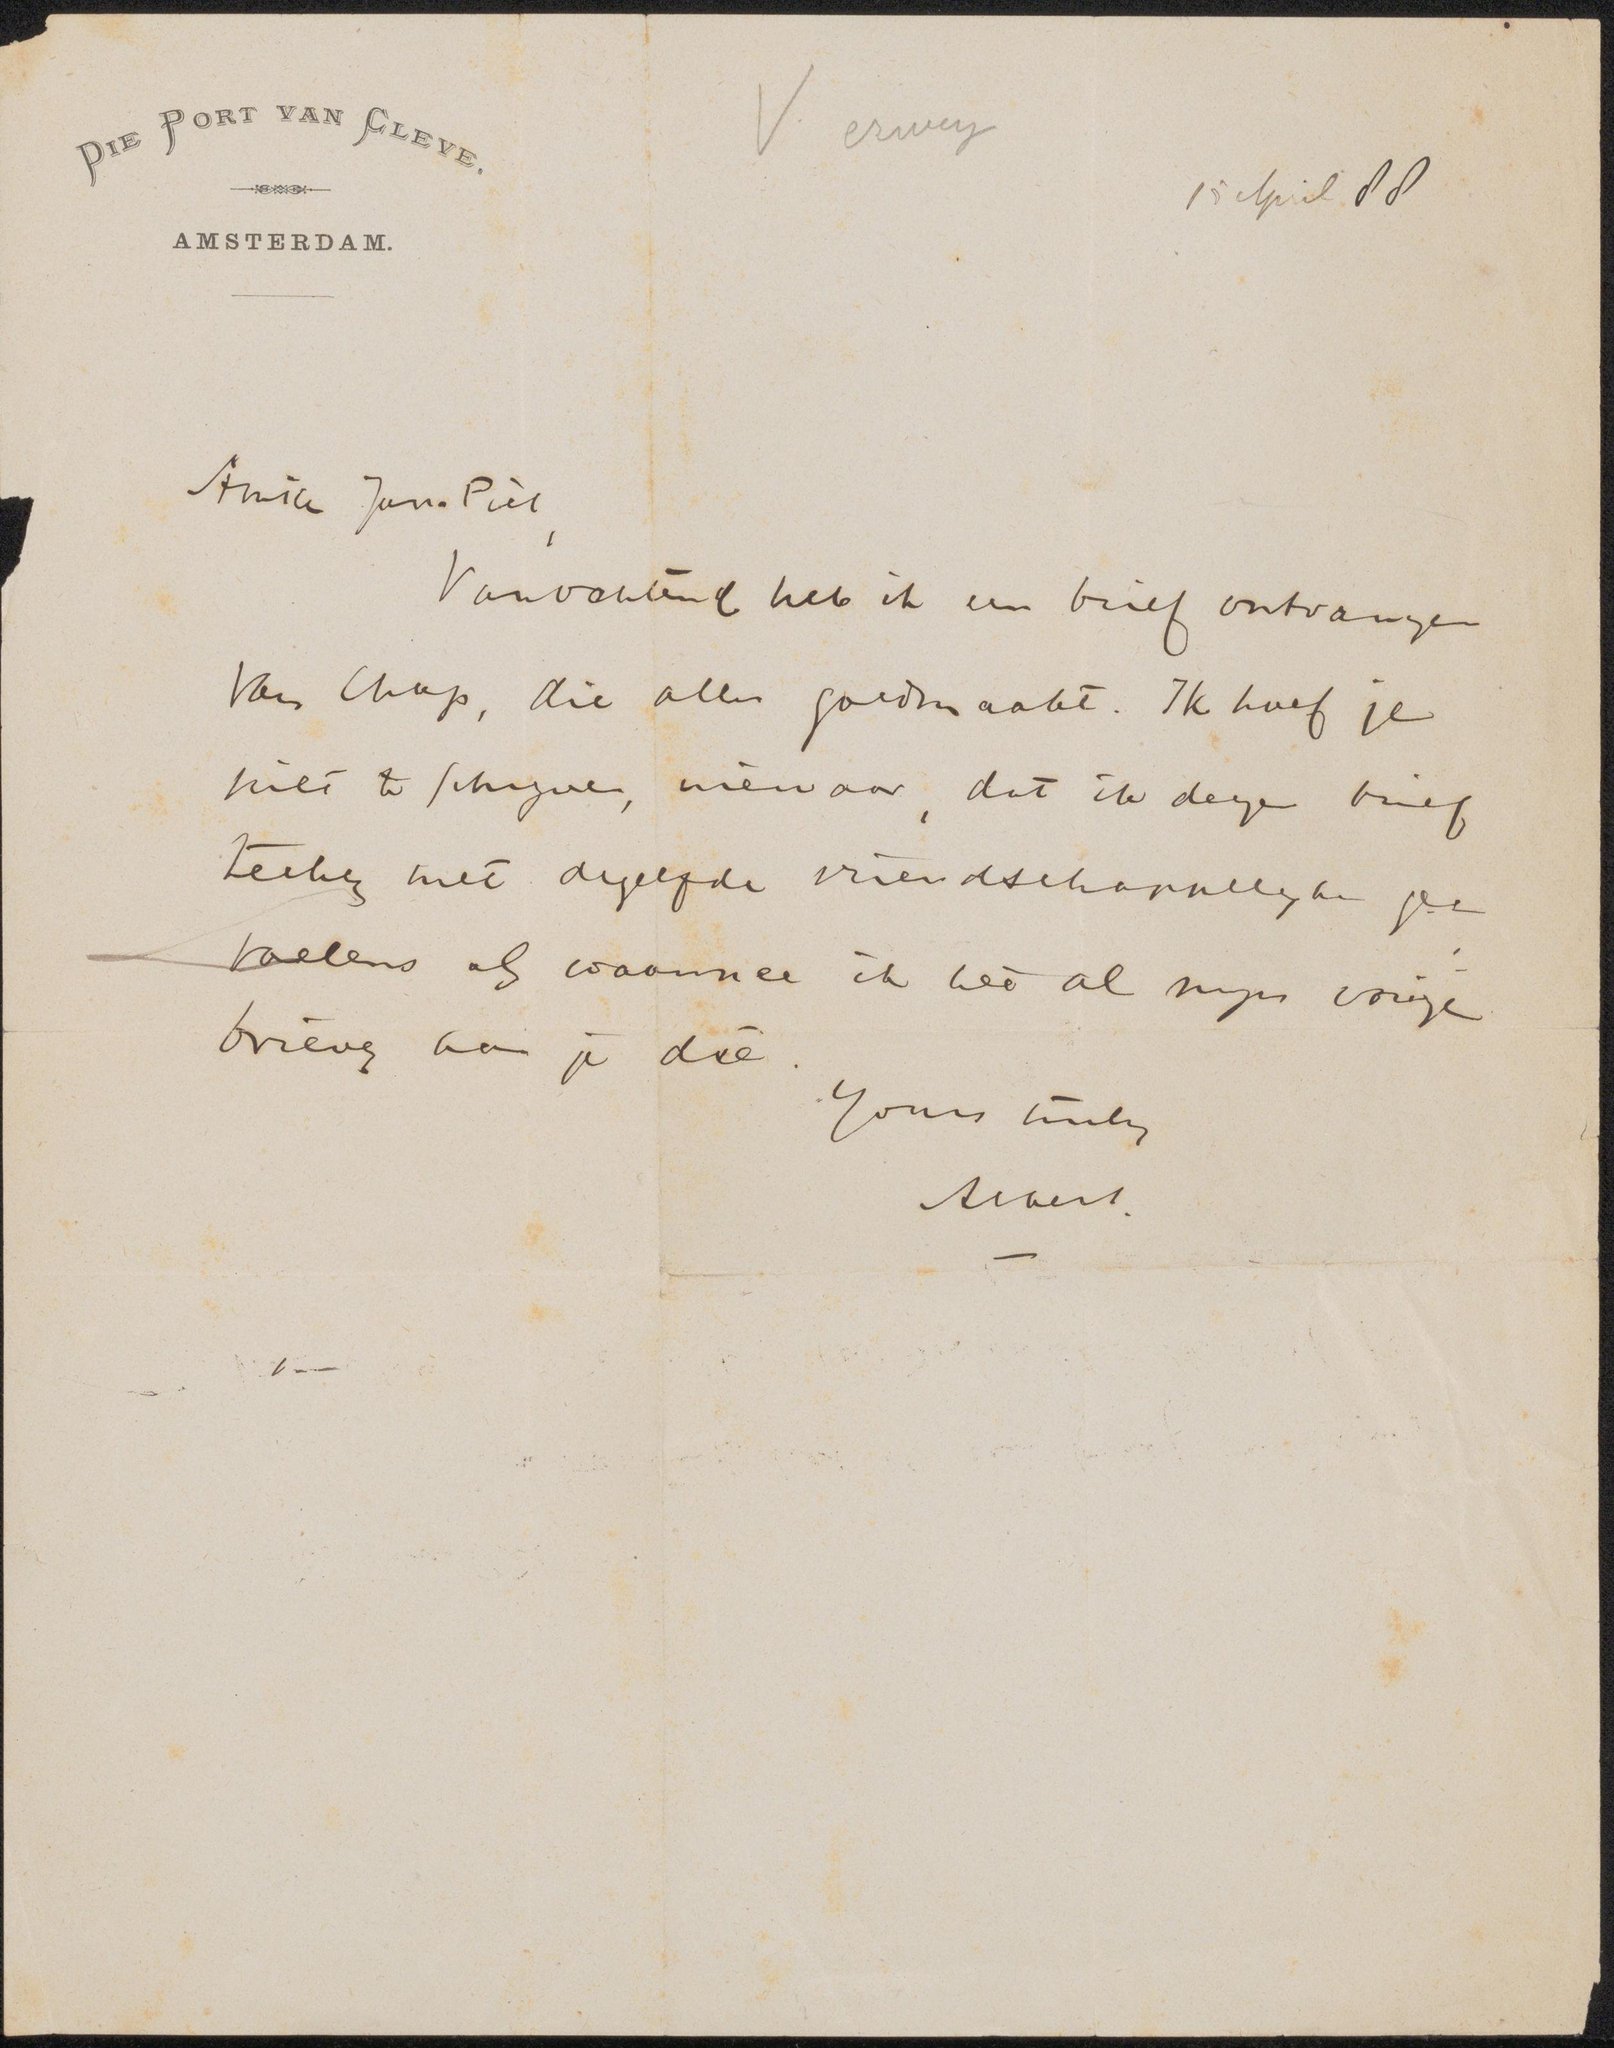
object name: letter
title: Brief aan Jan Veth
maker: albert verwey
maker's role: criticus, dichter, essayist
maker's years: 1865-1937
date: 1888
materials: ink, paper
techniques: pen, printing, writing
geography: amsterdam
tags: painter, draughtsman, designer, jan veth, chap van deventer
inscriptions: collector's mark: ‘RPK’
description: Opgenomen in: Verwey, Albert, Margaretha H. Schenkeveld, Rein van der Wiel: Briefwisseling 1 juli 1885 tot 15 december 1888, Amsterdam: EM. Querido's Uitgeverij B.V., 1993, p. 422.